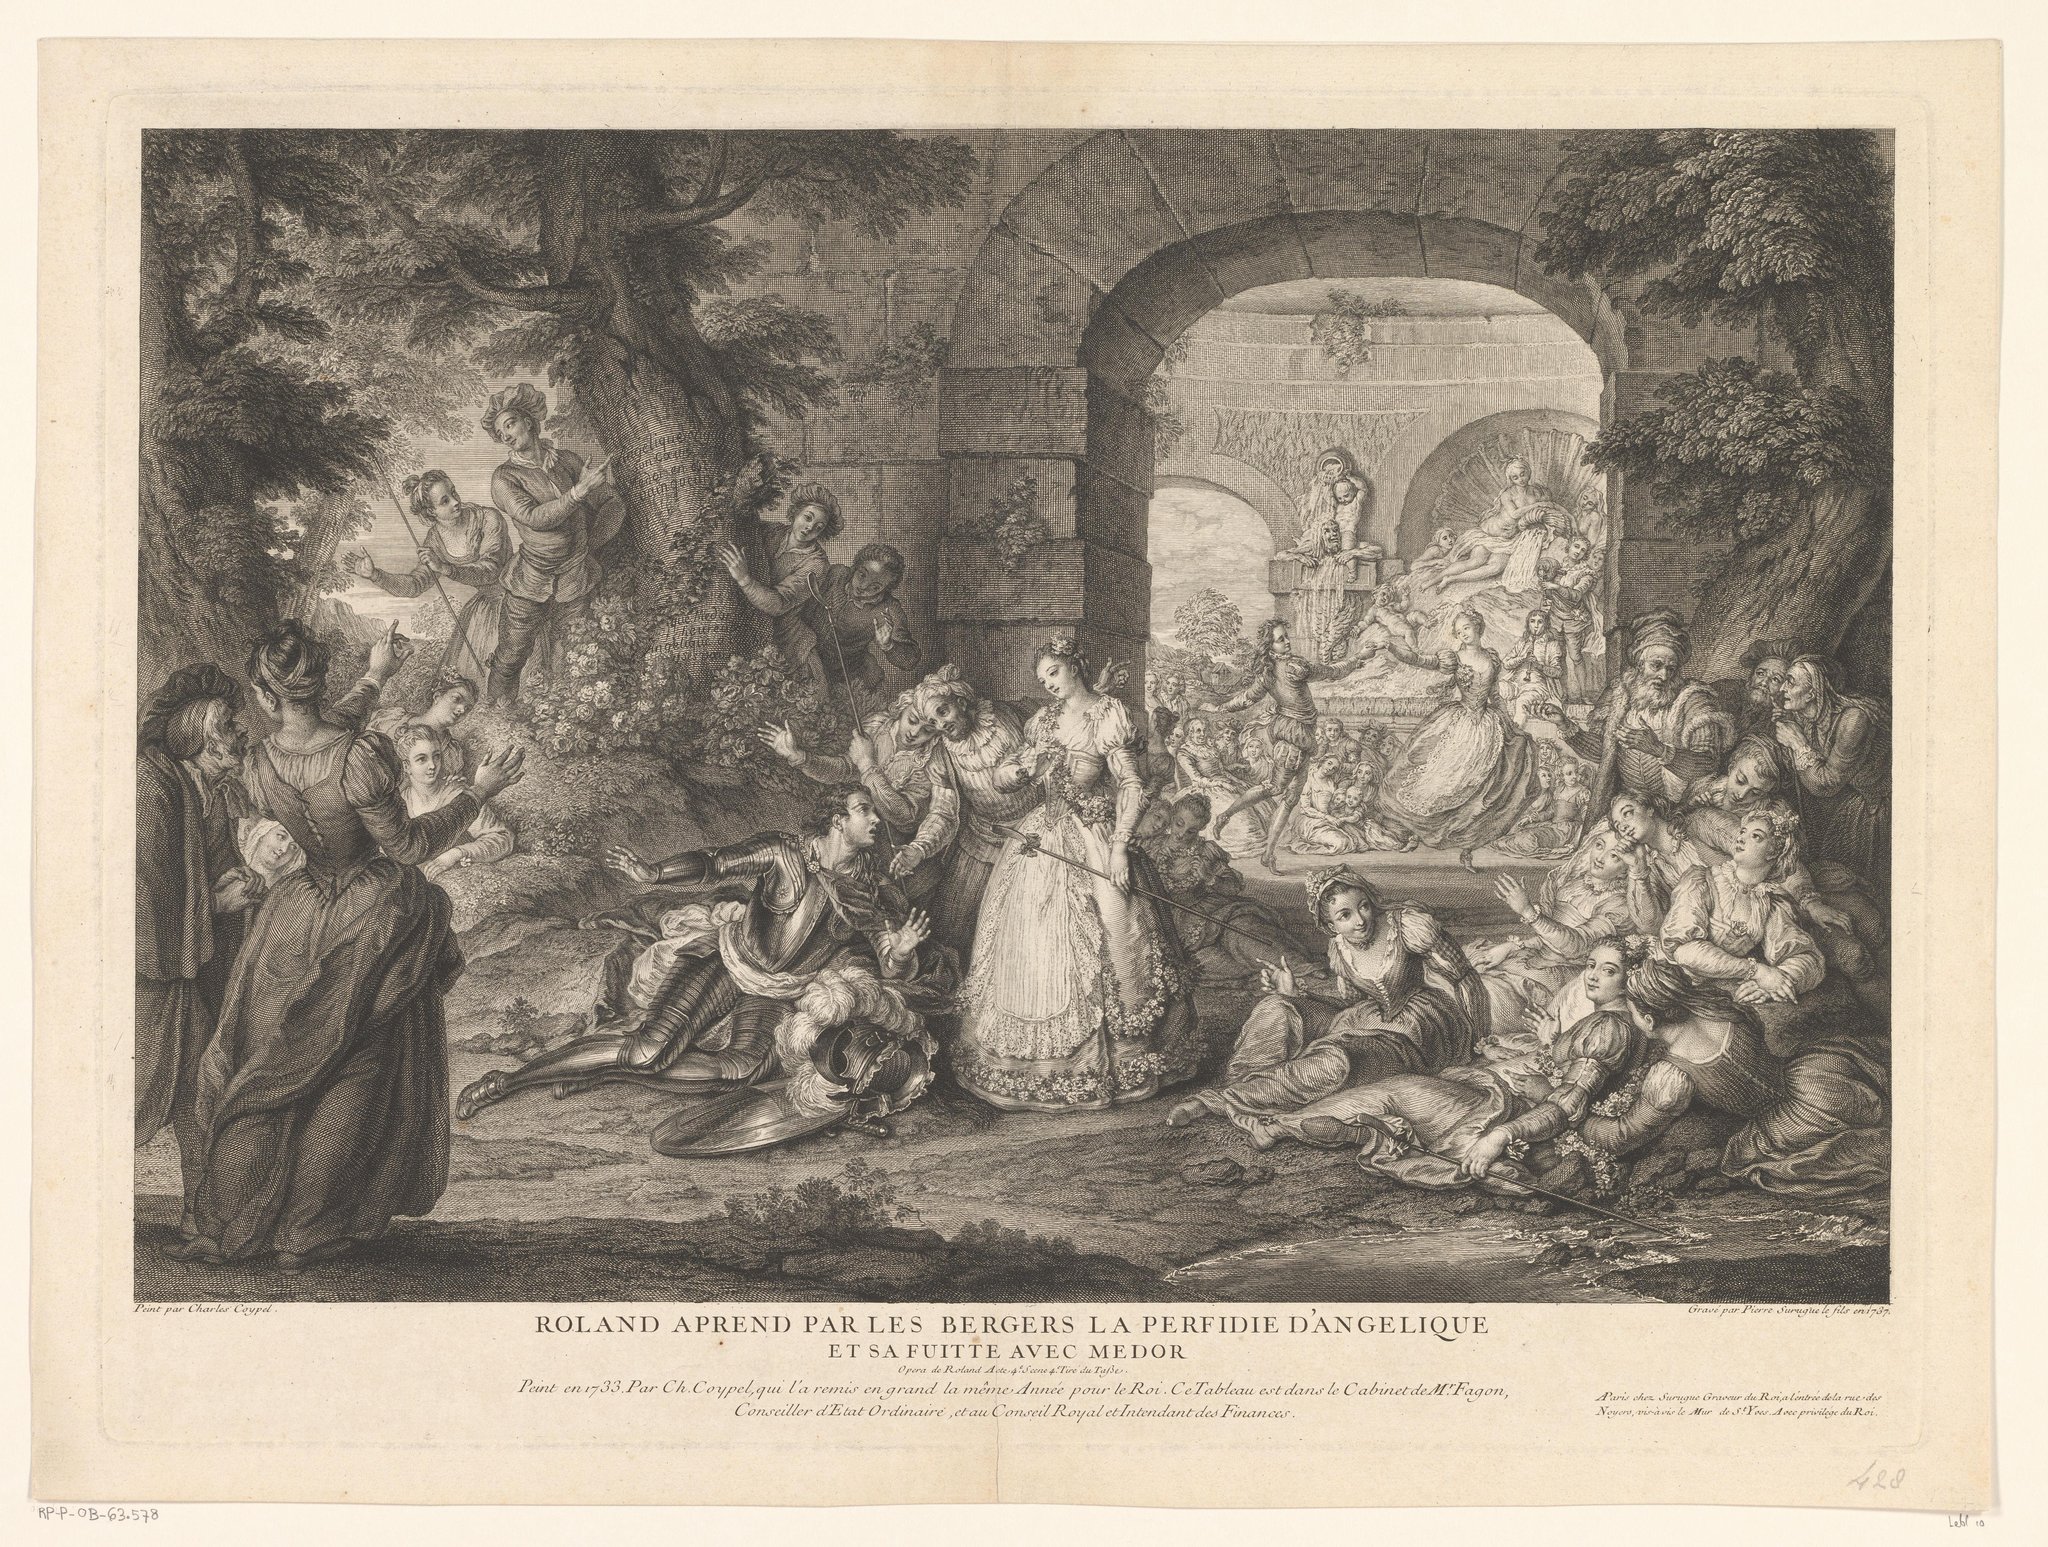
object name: print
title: Roland verneemt van de herders de ontrouw van Angelique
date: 1737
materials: paper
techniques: engraving, etching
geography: france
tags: roland, opera, adultery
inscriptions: collector's mark: Lugt 240